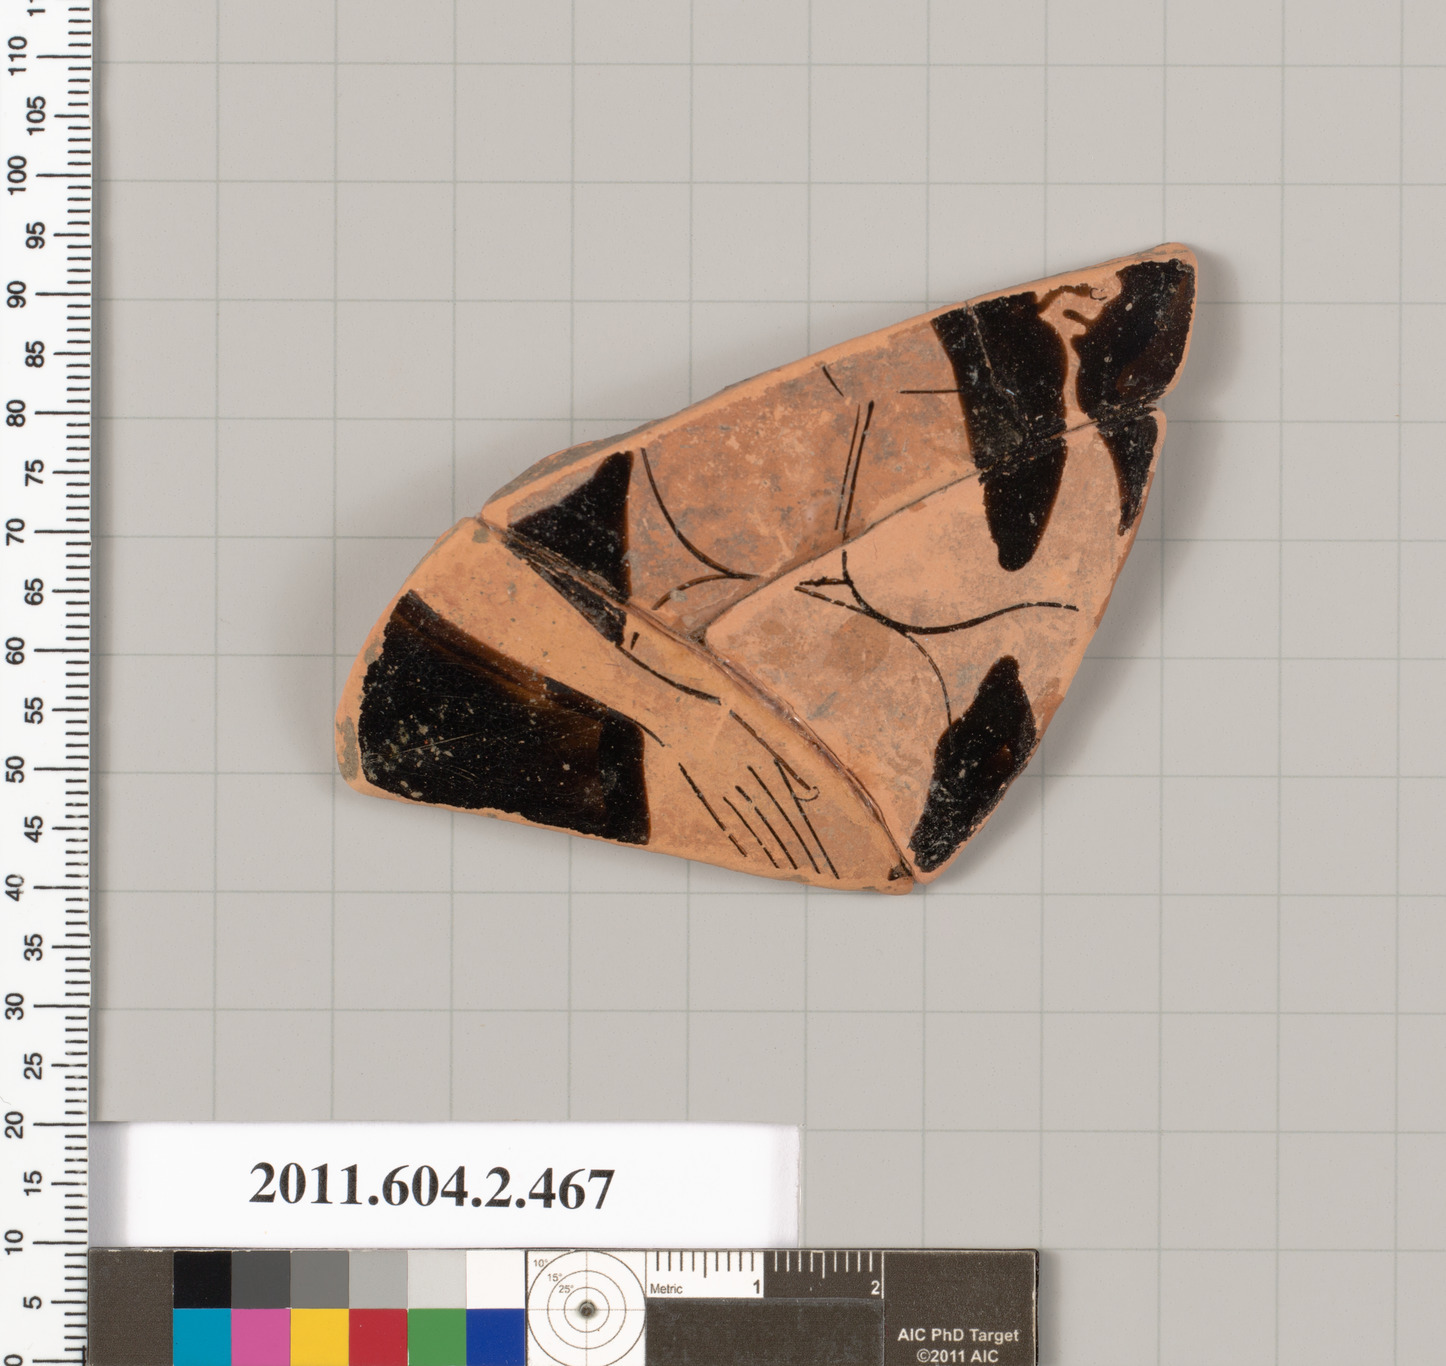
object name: column krater fragment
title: Terracotta fragment of a column-krater (bowl for mixing wine and water)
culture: greek, attic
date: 475-451 BCE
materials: terracotta